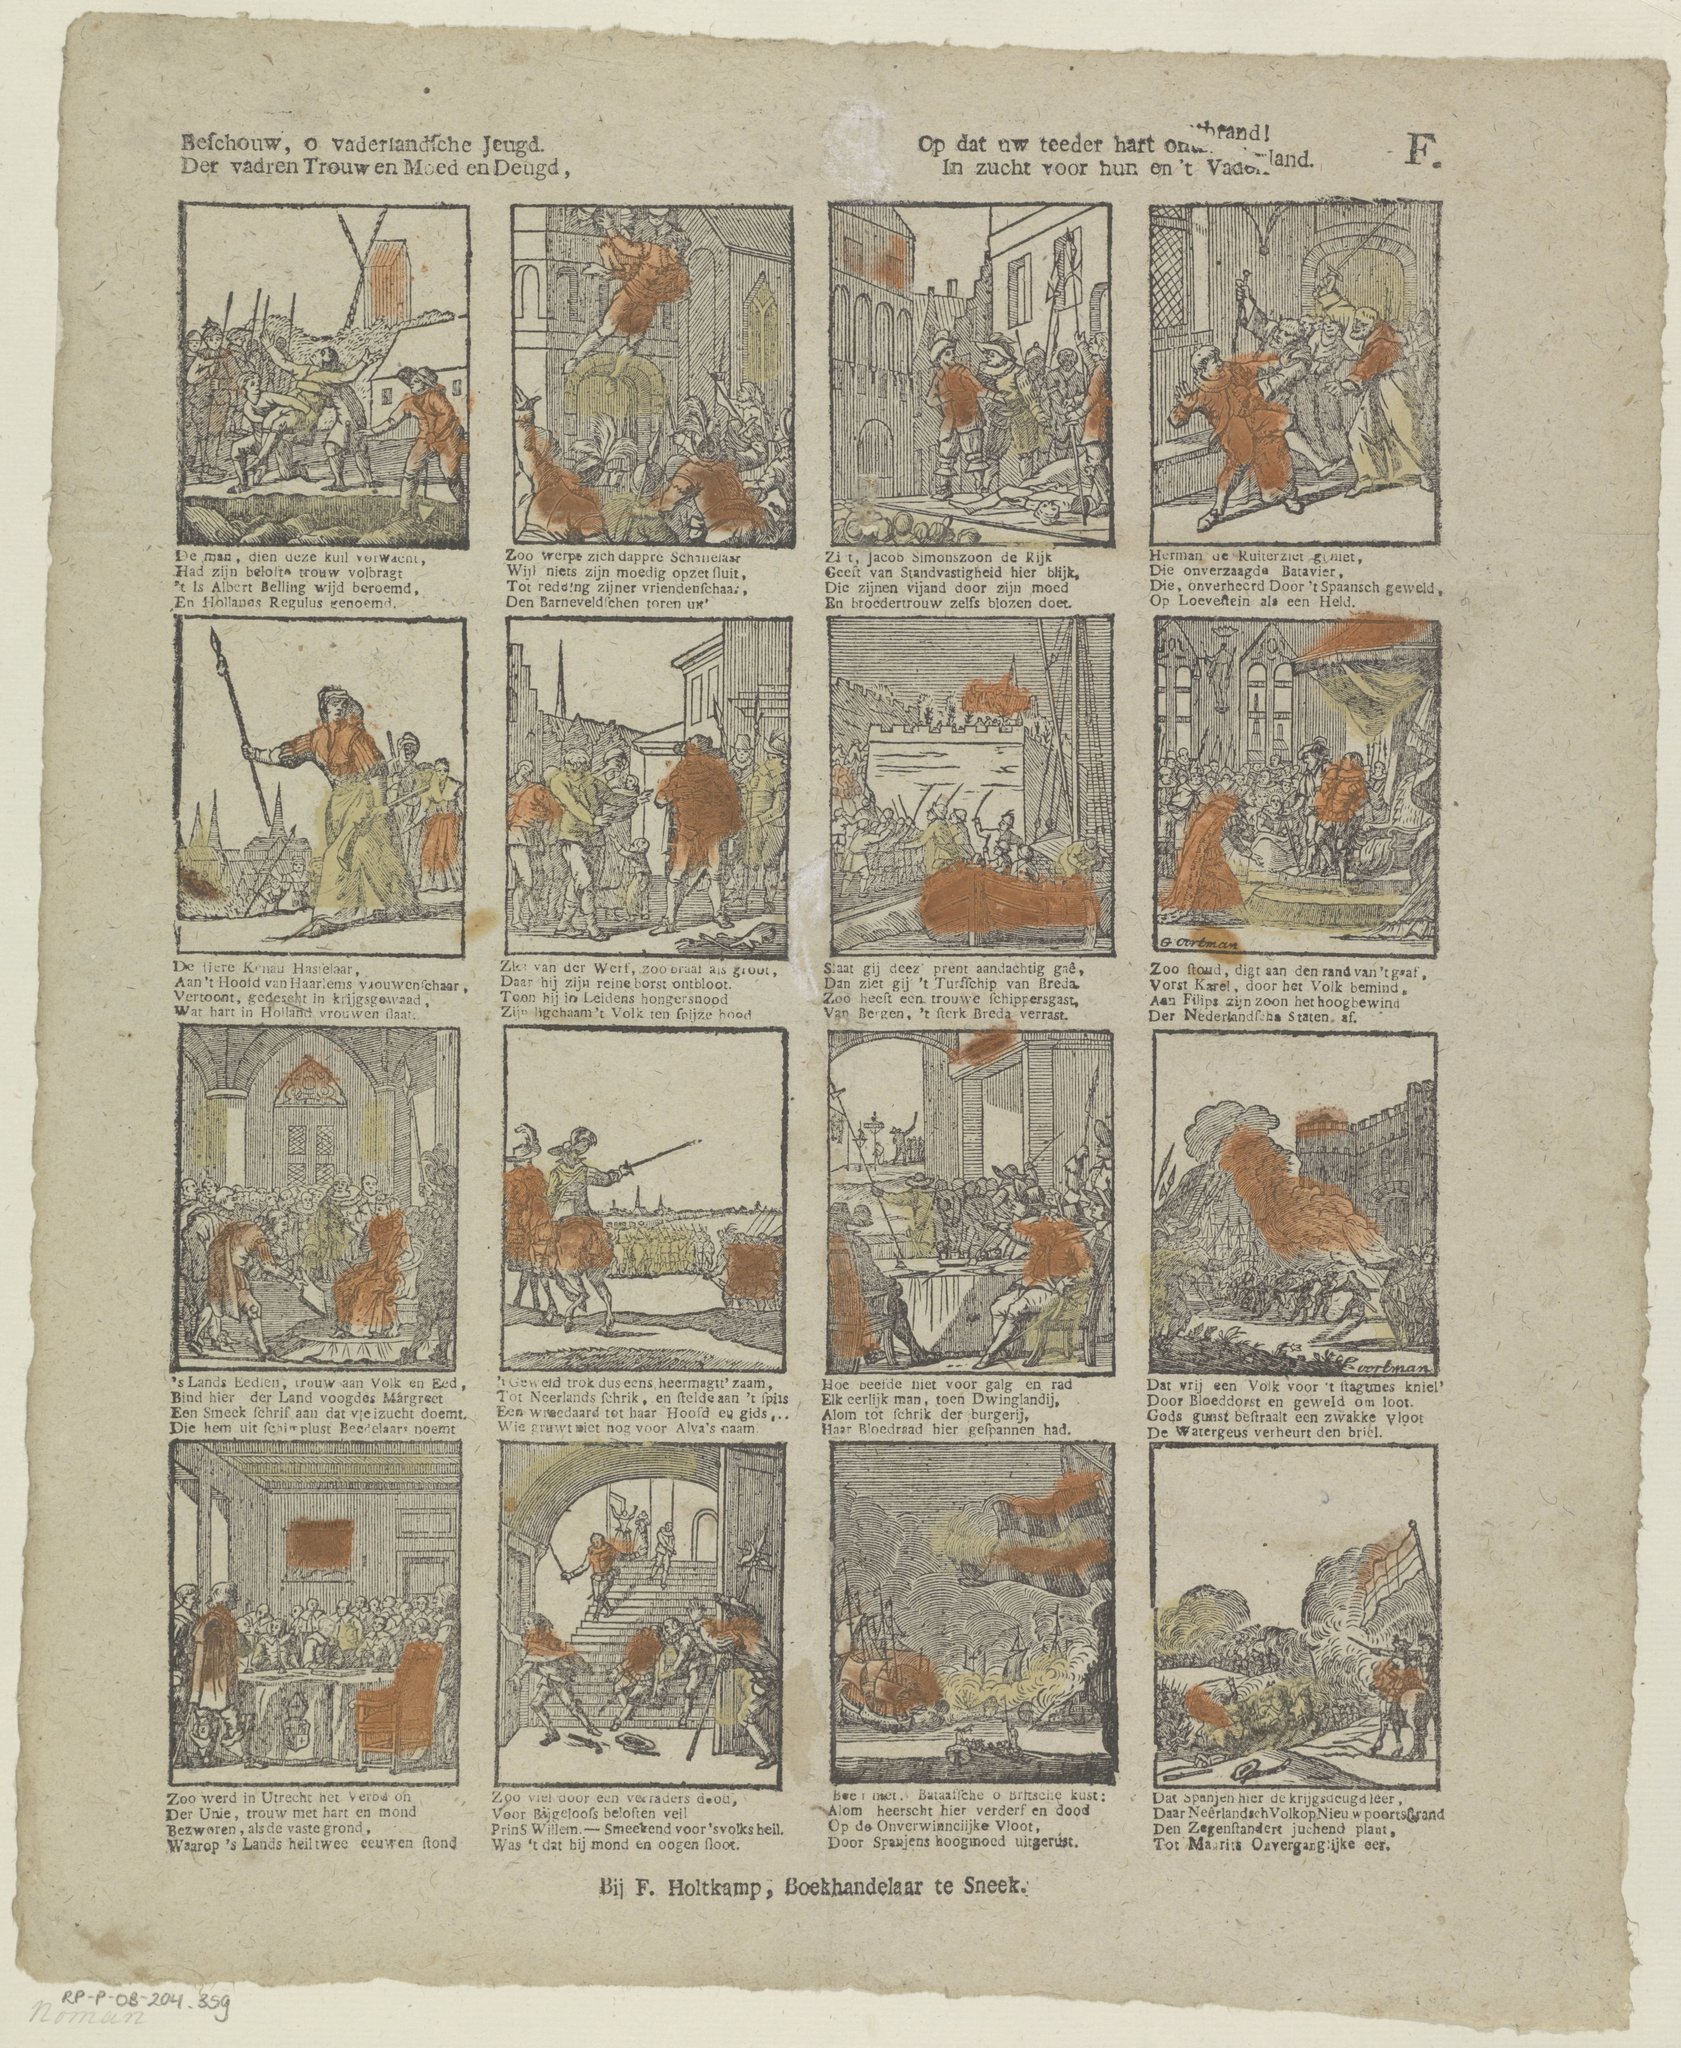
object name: popular print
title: Beschouw, o vaderlandsche jeugd! / Der vadren trouw en moed en deugd. / En dat uw teeder hart ontbrand'/ In zucht voor hun en 't vaderland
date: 1806-1830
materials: paper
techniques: colour, letterpress printing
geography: netherlands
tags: philip ii of spain, delft, william i (prince of orange), the hague, maurice (prince of orange), fernando álvarez de toledo (3rd duke of alba), loevestein castle, amsterdam, ghent, charles v (holy roman emperor and king of spain), history, leiden, utrecht, battle of nieuwpoort, union of utrecht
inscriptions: collector's mark: Lugt 2760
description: Blad met 16 voorstellingen van gebeurtenissen uit de vaderlandse geschiedenis, zoals Jan van Schaffelaar die van de toren springt te Barneveld en de inname van Breda in 1590. Onder elke afbeelding een vierregelig vers. Gemerkt rechtsboven: F.